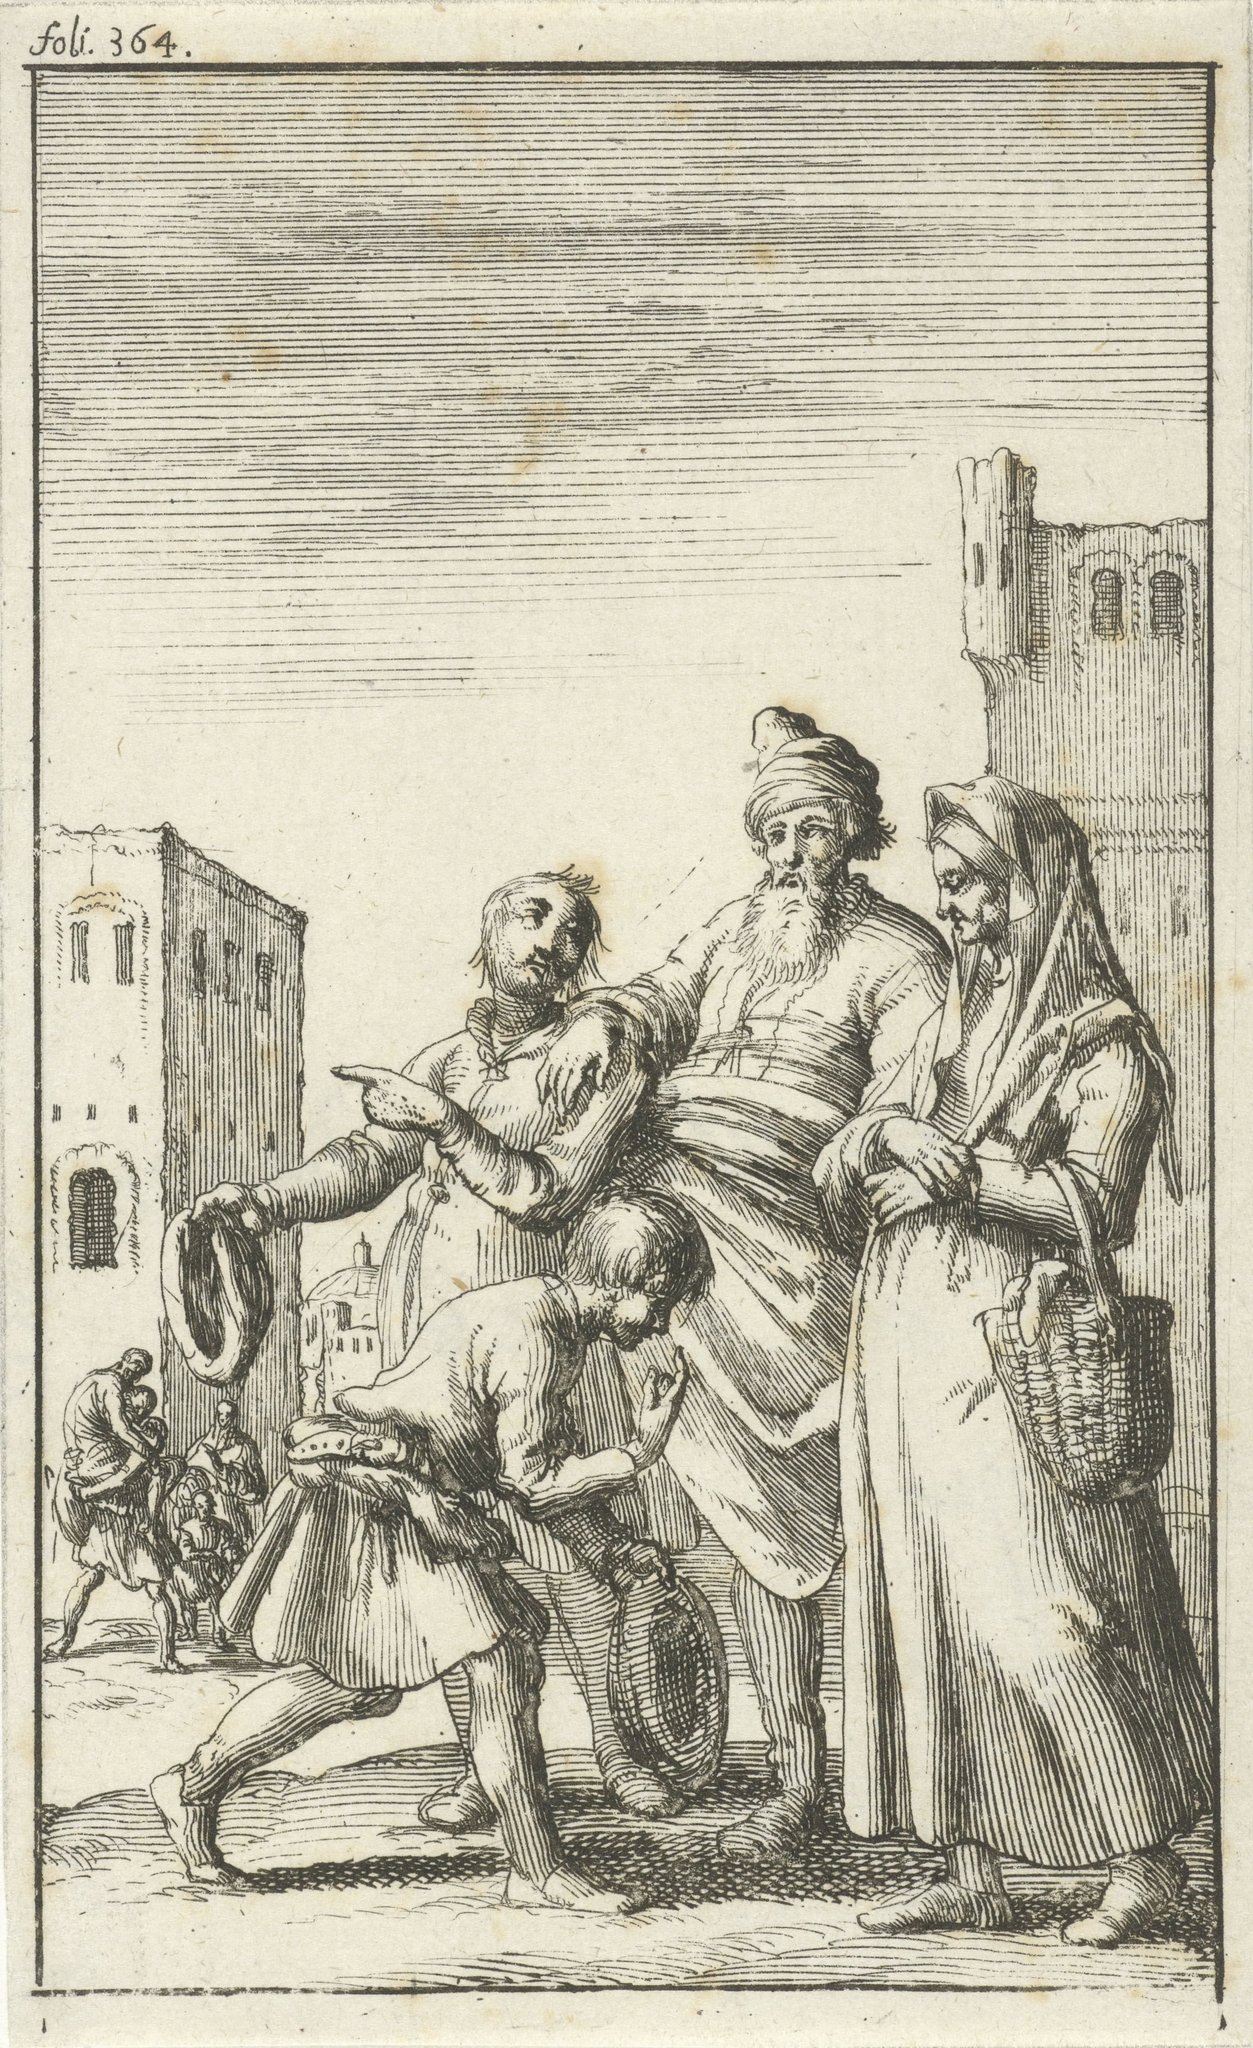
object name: print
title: Jongeman neemt zijn hoed af om een bejaard echtpaar te groeten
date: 1685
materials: paper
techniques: etching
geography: amsterdam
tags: baring the head, lifting one's hat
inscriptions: collector's mark: Lugt 2228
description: Illustratie uit: Hondorffius, Andreas. De tien geboden des Heeren. Amsterdam: Jan Bouman, 1685.